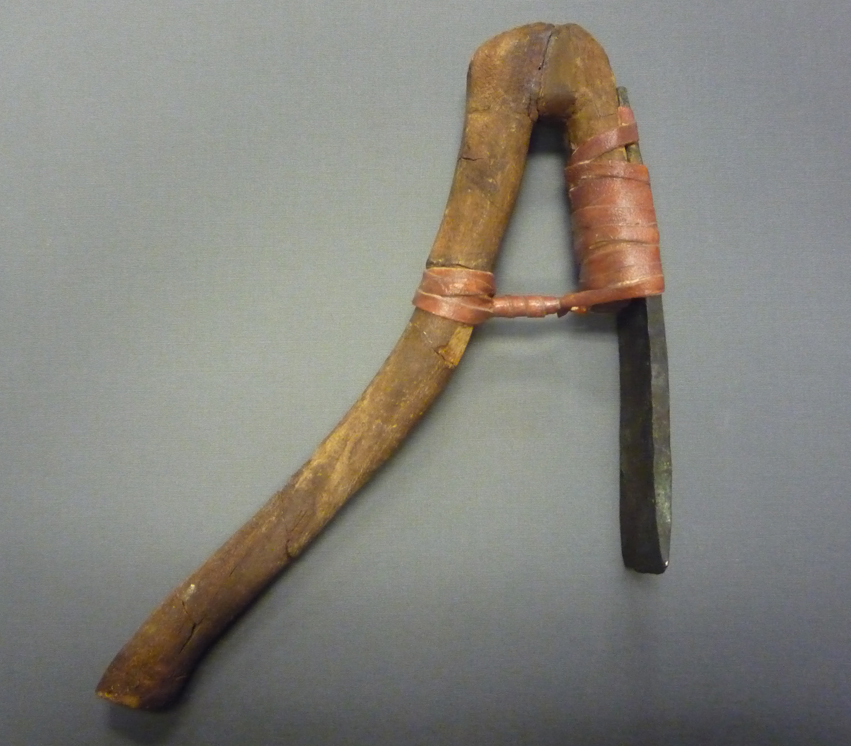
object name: adze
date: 1550-1295 BCE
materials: bronze, copper alloy, leather, wood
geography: egypt